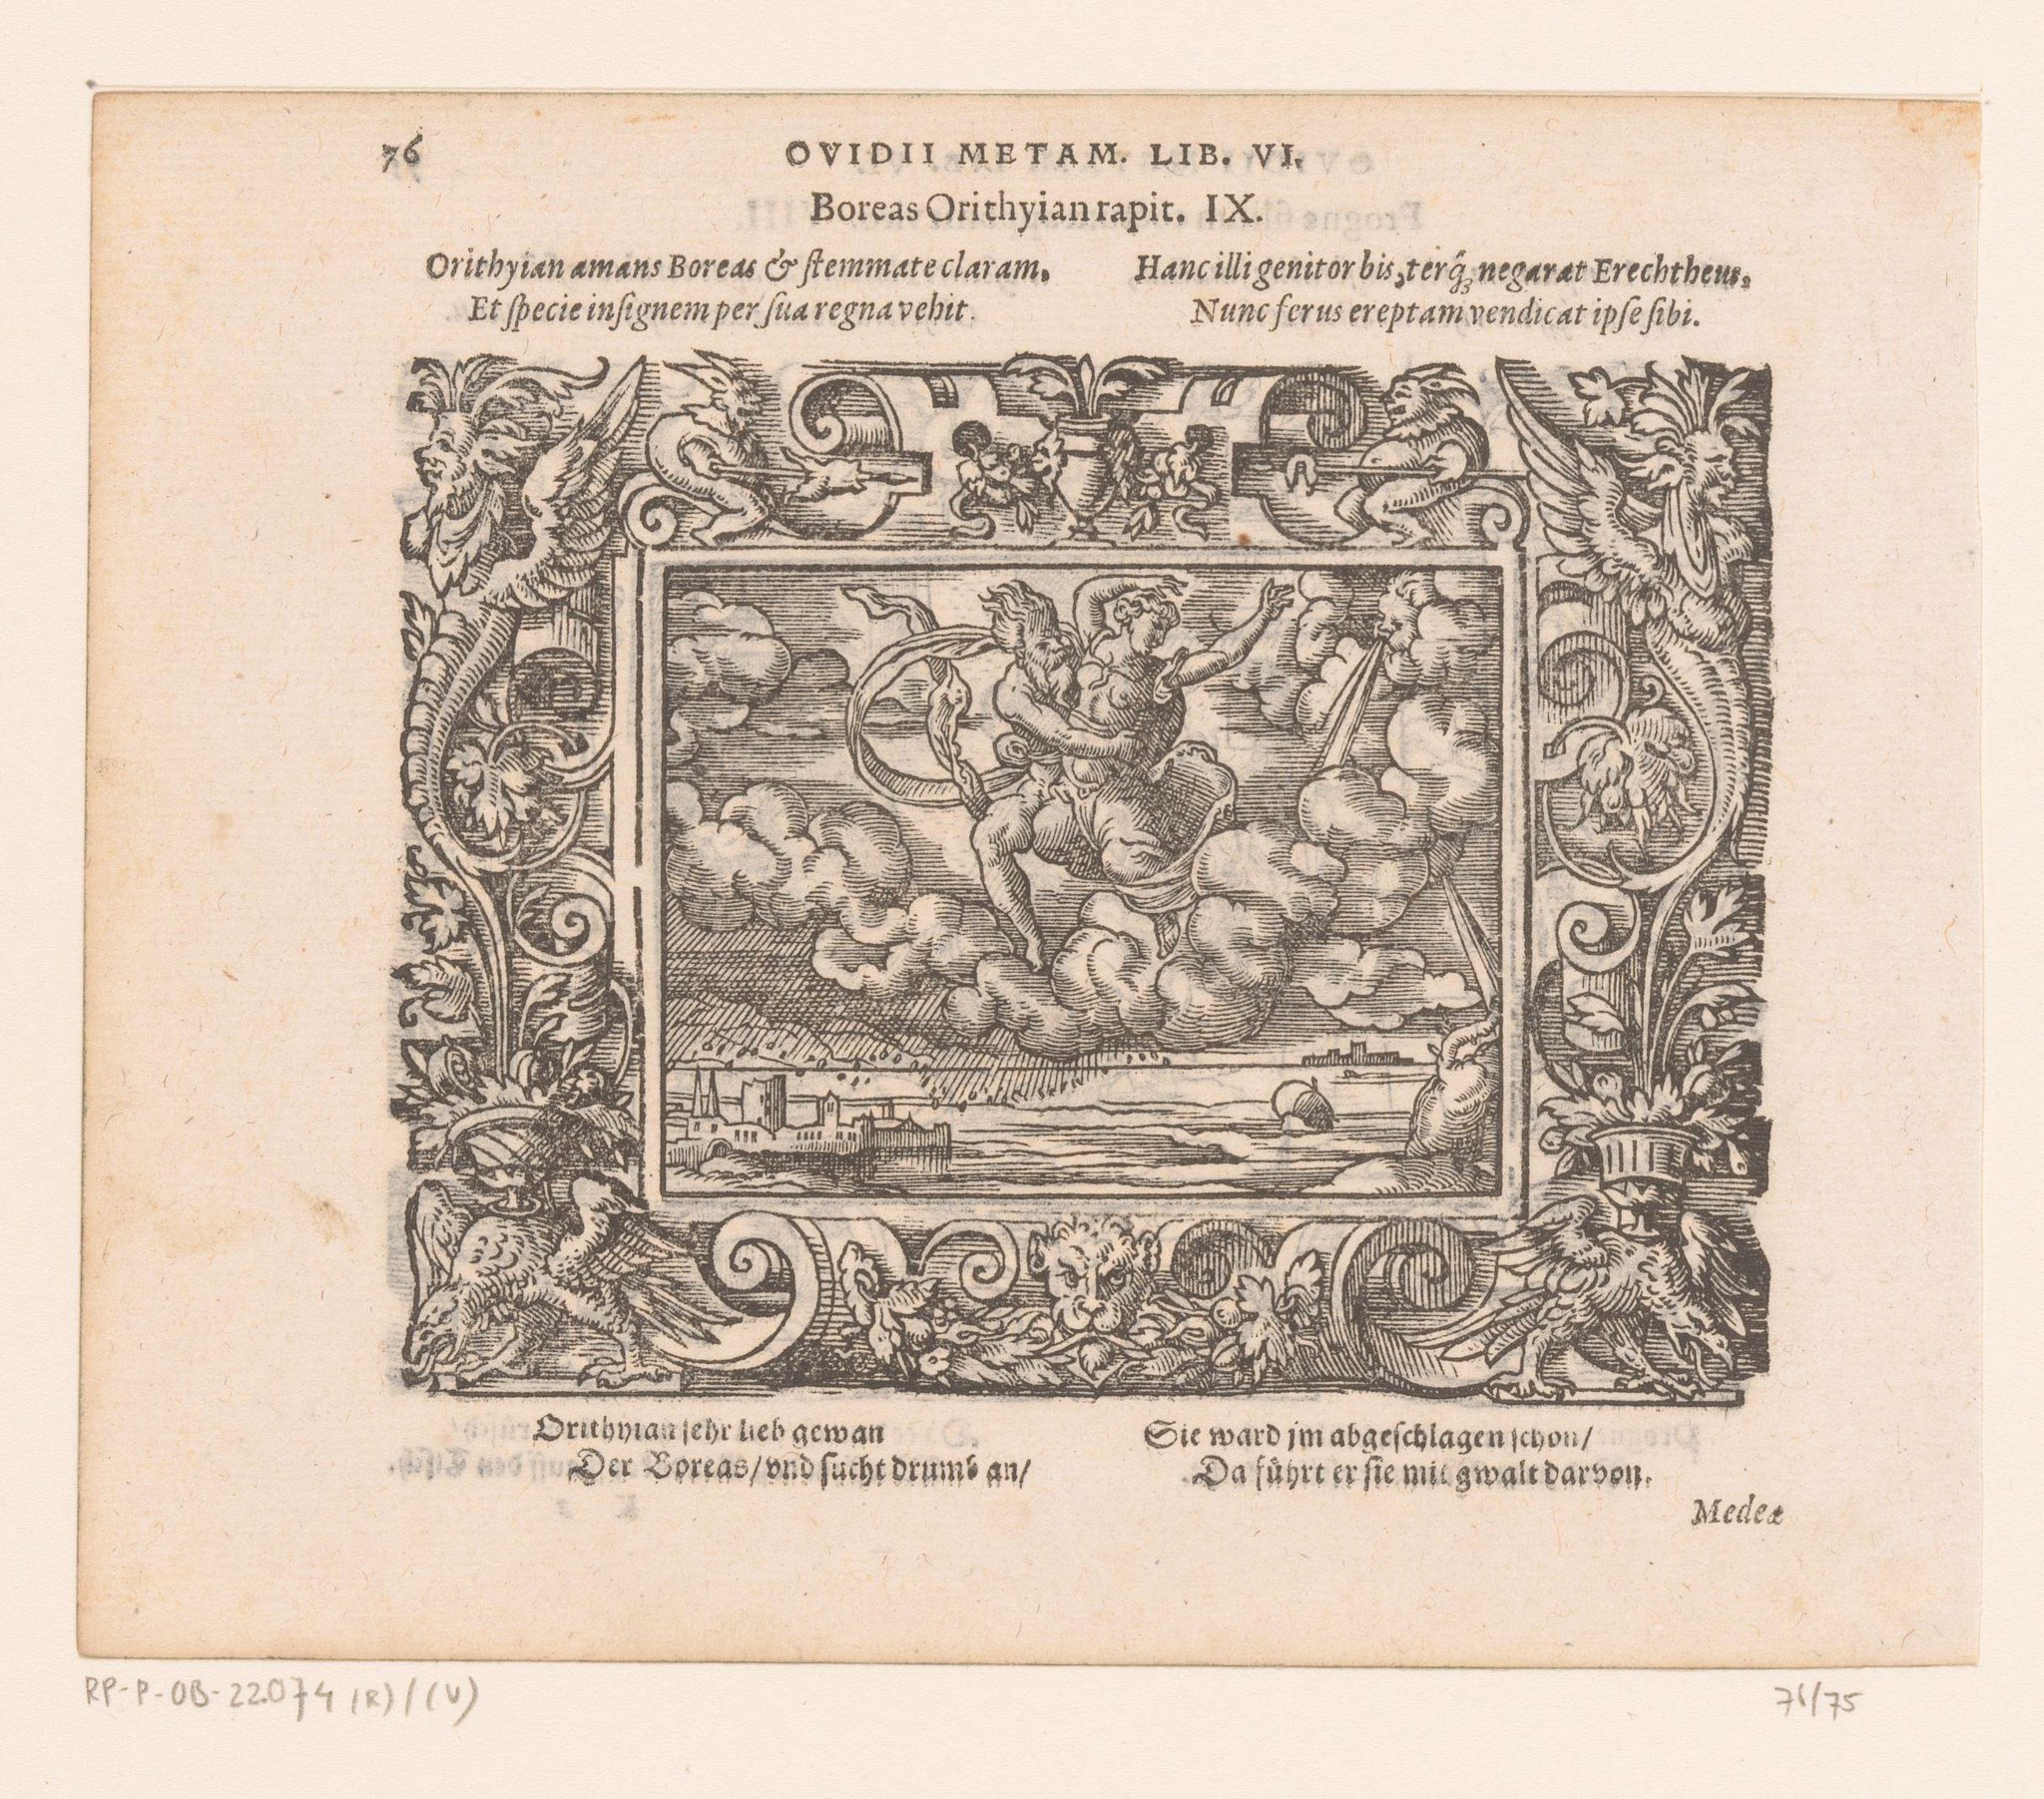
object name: print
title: Boreas Orithyian rapit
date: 1569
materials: paper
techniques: letterpress printing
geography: frankfurt am main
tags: boreas abducting orithyia, scrollwork, strapwork ~ ornament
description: Illustratie bij de Metamorfosen van Ovidius, afkomstig uit de publicatie: Posthius, Johannes. Tetrasticha in Ovidii metam. Frankfurt am Main: Georg Rab en Sigmund Feyerabend en erven Weigand Han, 1569. De voorstellingen en ornamentranden van deze boekillustraties zijn van twee aparte blokken gedrukt. Beide werden afzonderlijk van elkaar ook gebruikt voor andere publicaties, en de ornamentranden werden eveneens binnen deze publicatie meerdere keren gebruikt.